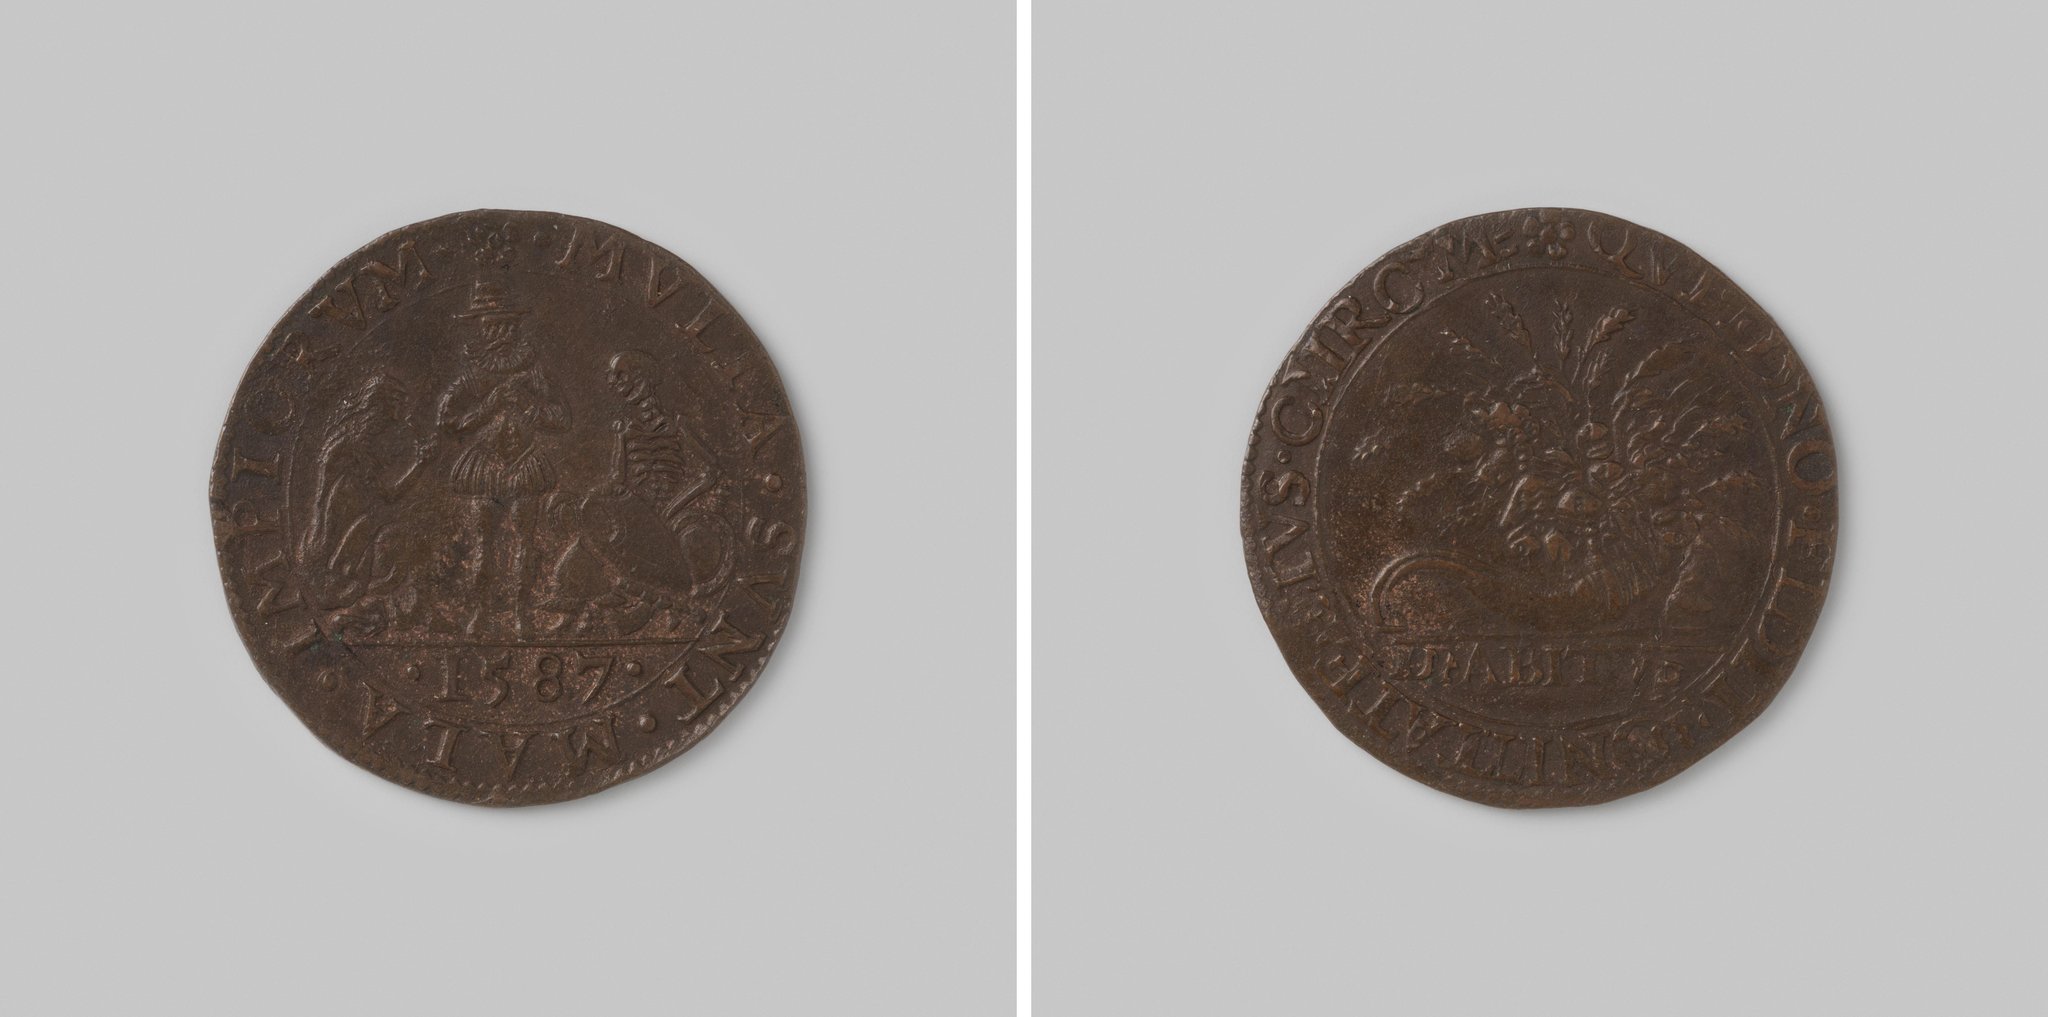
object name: history medal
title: Rekenpenning uit Dordrecht op de hongersnood in Artois 1587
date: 1587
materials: copper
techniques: striking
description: Koperen penning, op de voorzijde een man tussen de Hongersnood en de Dood, met afsnedetekst en omschrift, op de keerzijde een hoorn des overvloeds met graan, met afsnedetekst en omschrift.